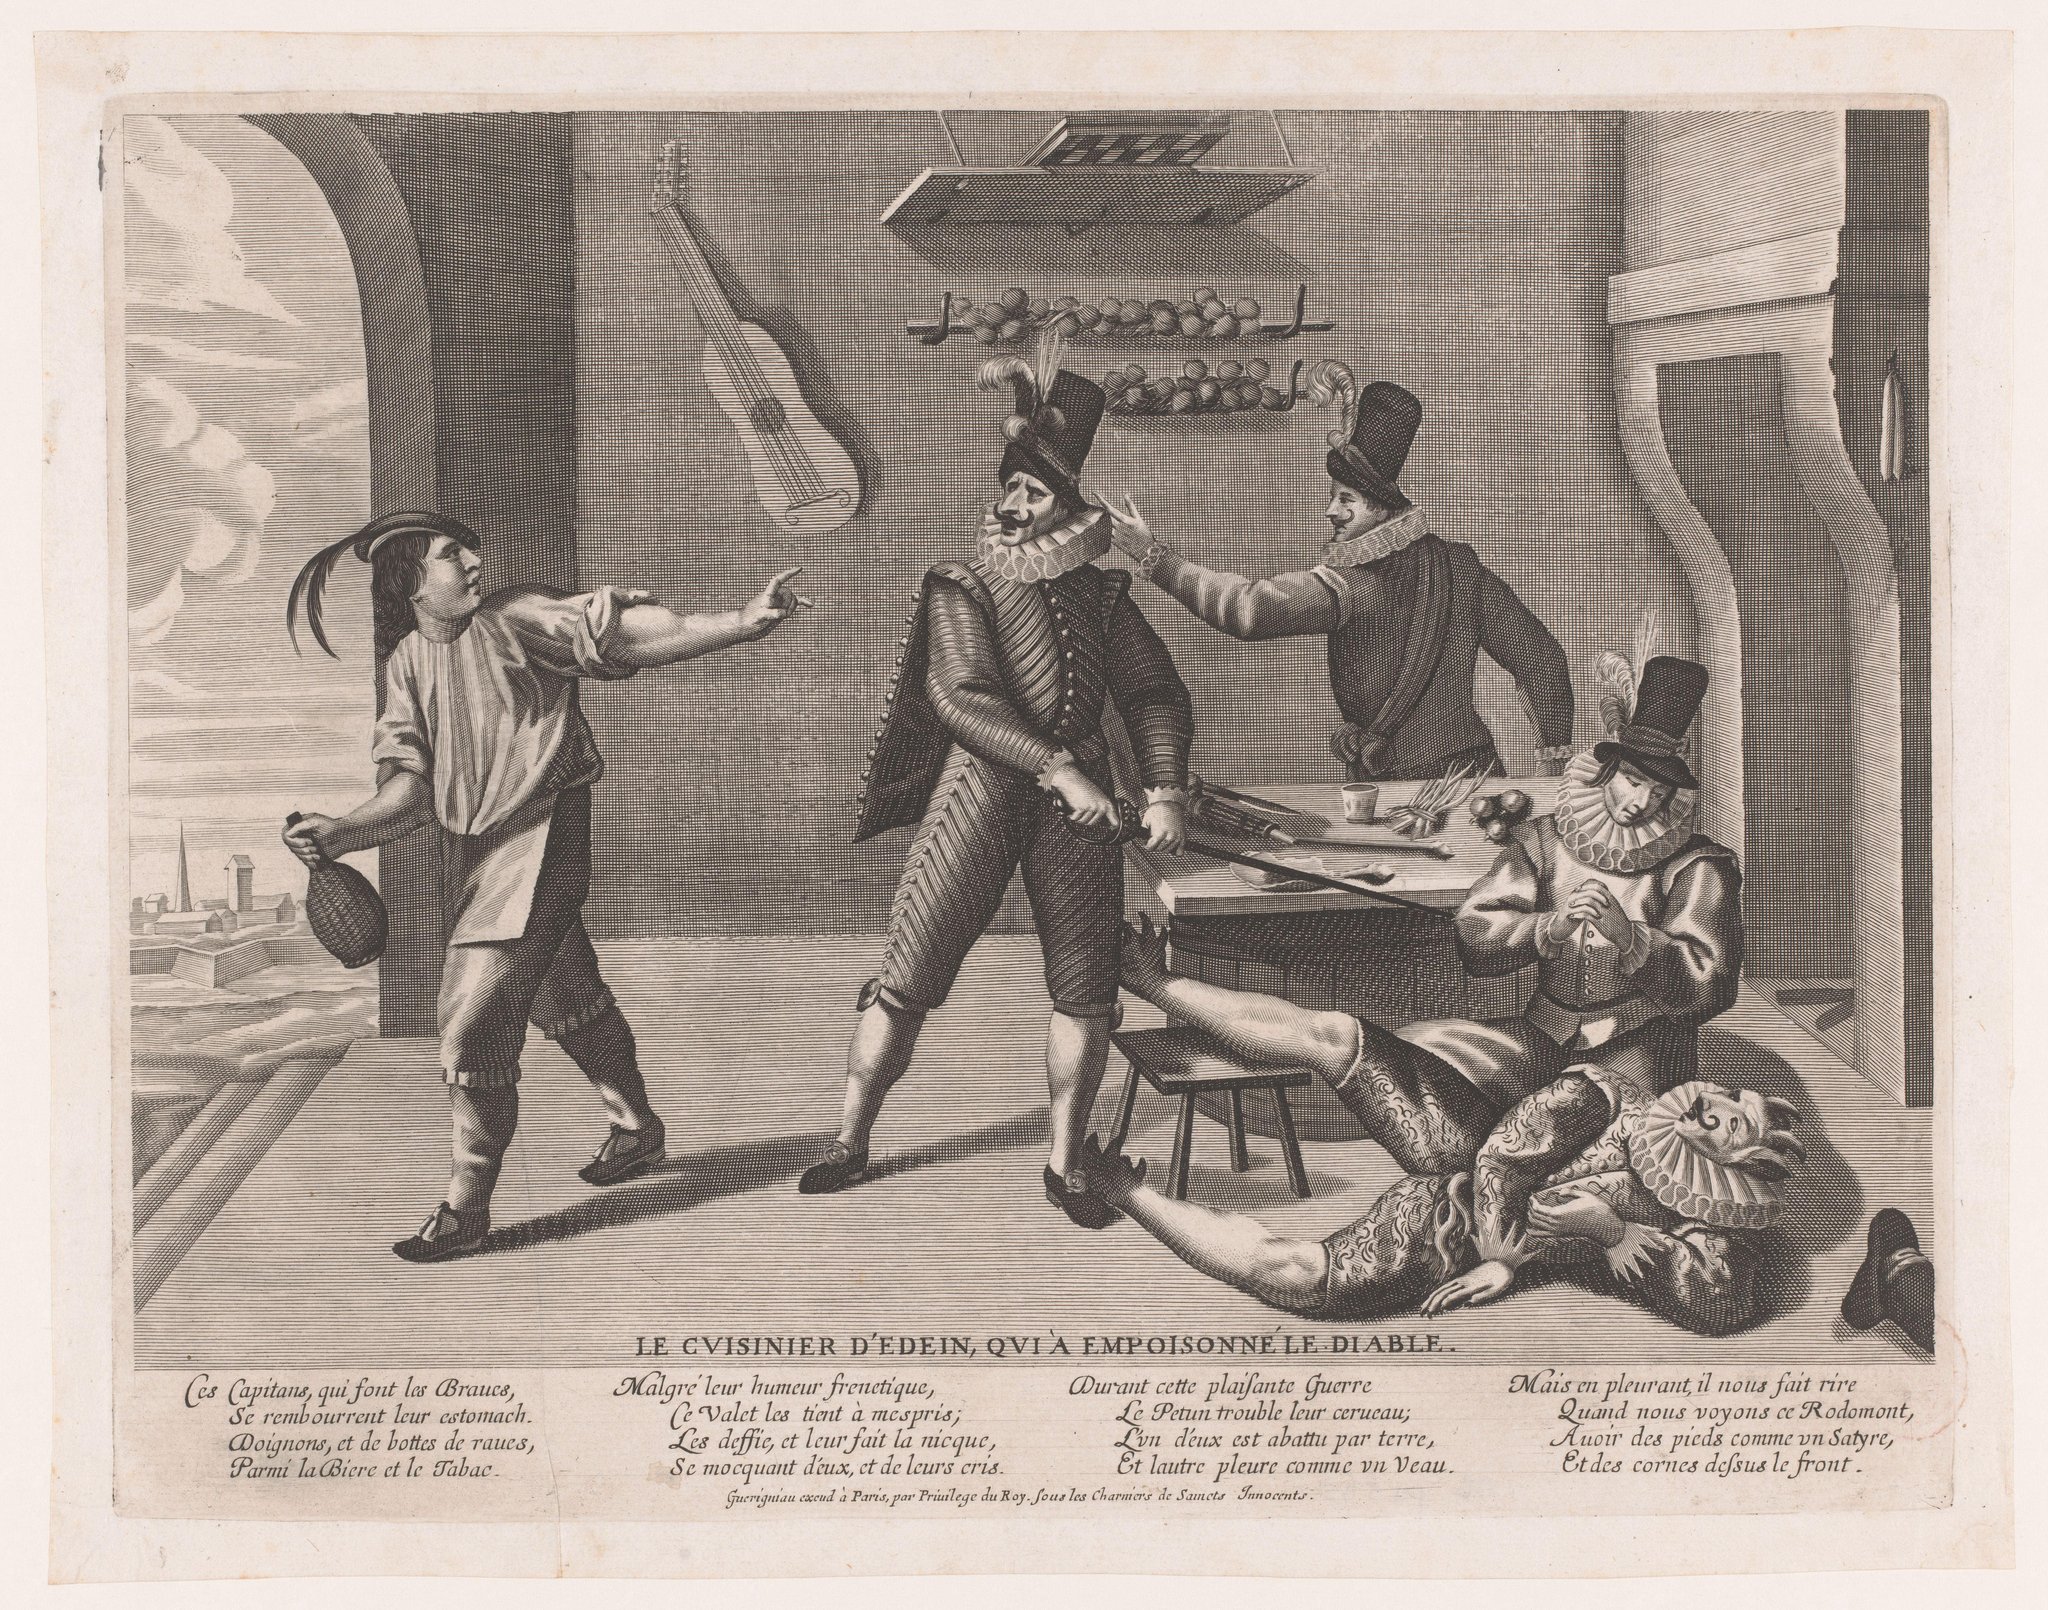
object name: cartoon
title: Spotprent van Spanjaarden en een kok die de duivel vergiftigt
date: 1650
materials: paper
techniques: engraving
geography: france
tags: europeans: spaniards, poisoning, human-shaped devil, political caricatures and satires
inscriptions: collector's mark: Lugt 240